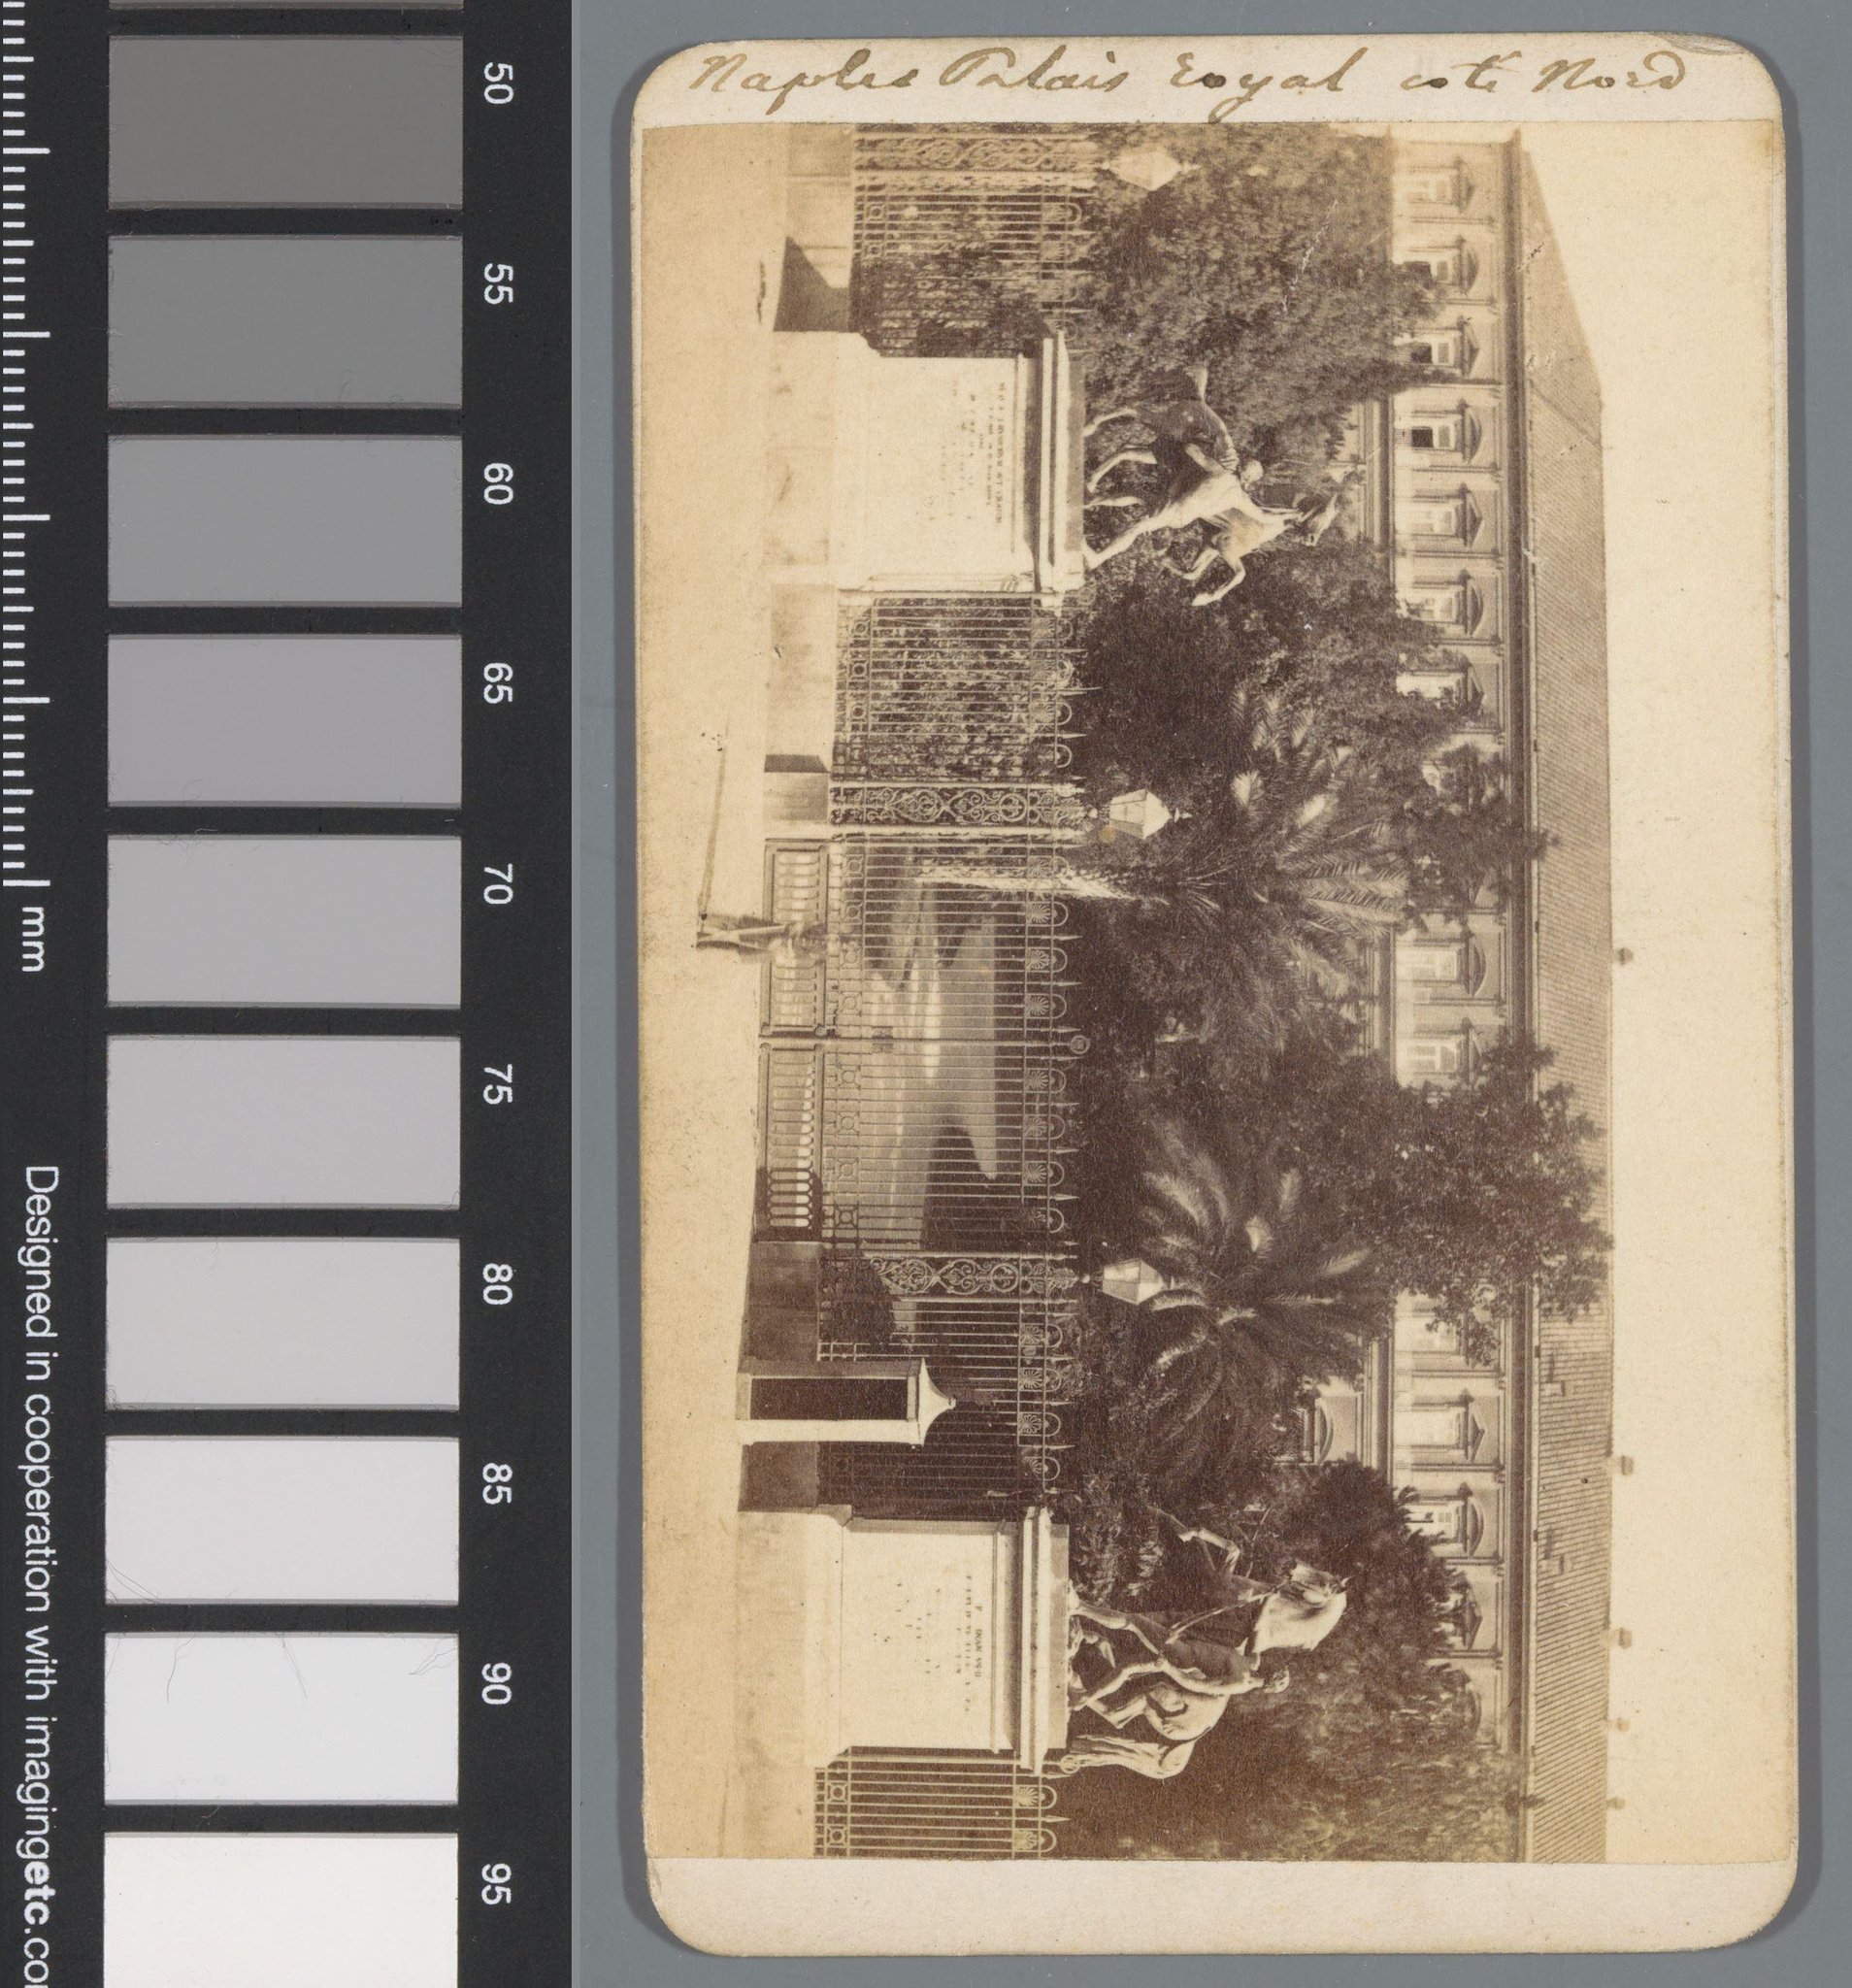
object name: carte de visite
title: Koninklijk paleis van Napels, gezien vanuit het noorden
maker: Anonymous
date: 1855-1885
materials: cardboard, paper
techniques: albumen print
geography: naples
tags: palace